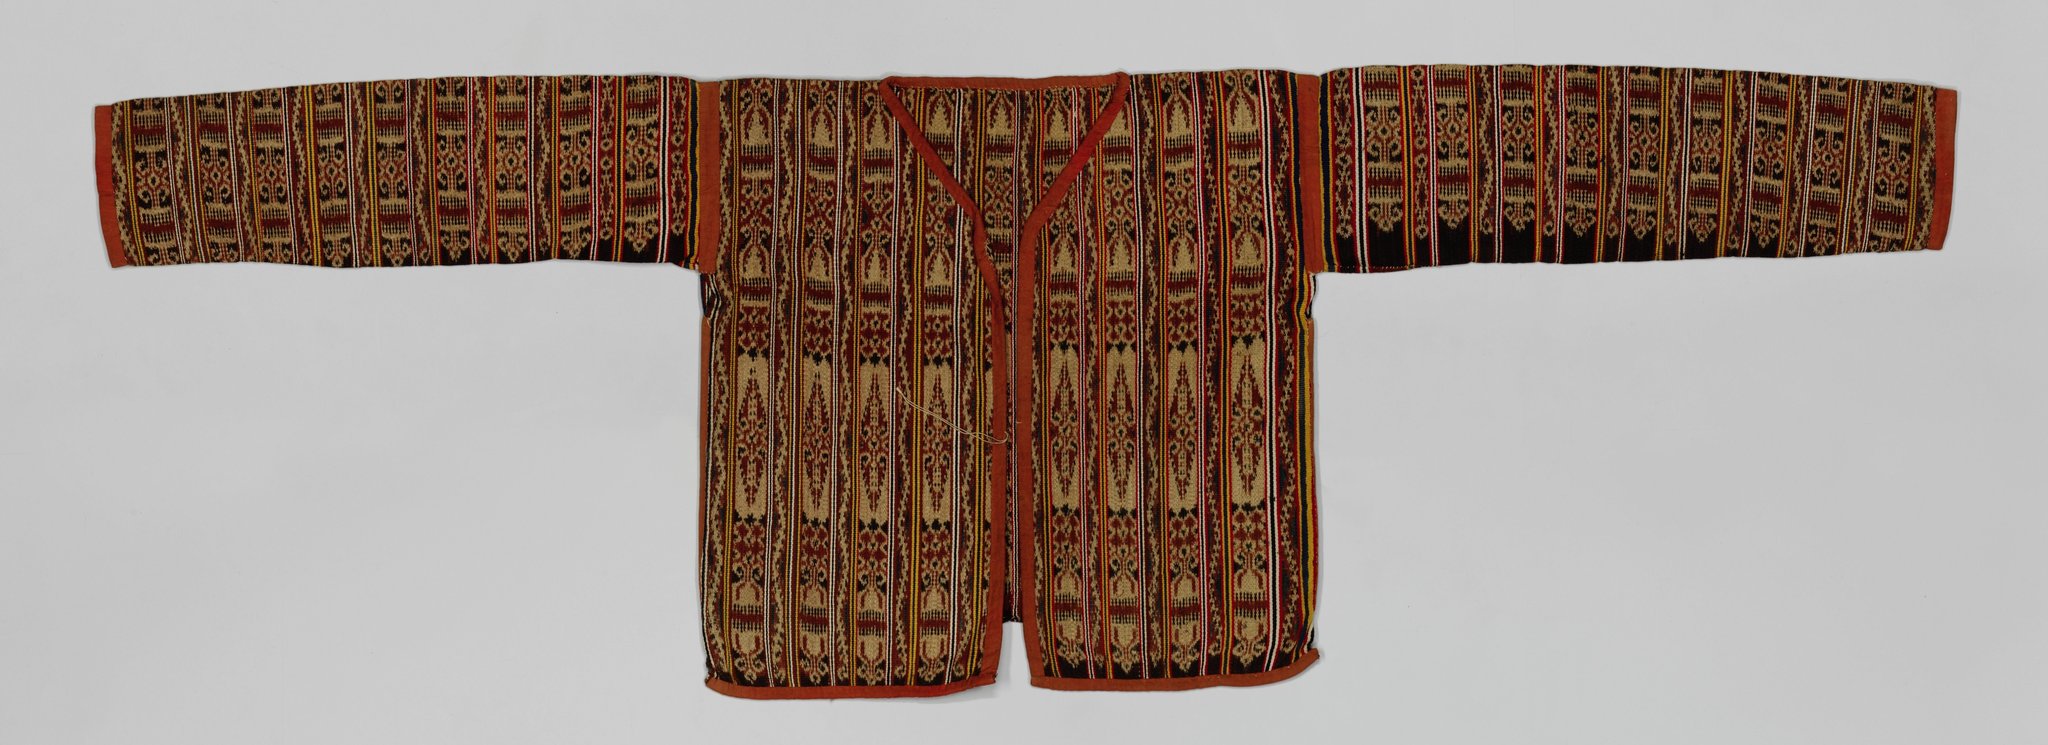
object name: coat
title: Jacket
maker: Anonymous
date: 1900-1949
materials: cotton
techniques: weave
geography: sarawak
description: This jacket was made for a man. It consists of five separate panels with geometric patterns in ikat. The pieces panels are sewn together and the edges trimmed with plain red fabric.